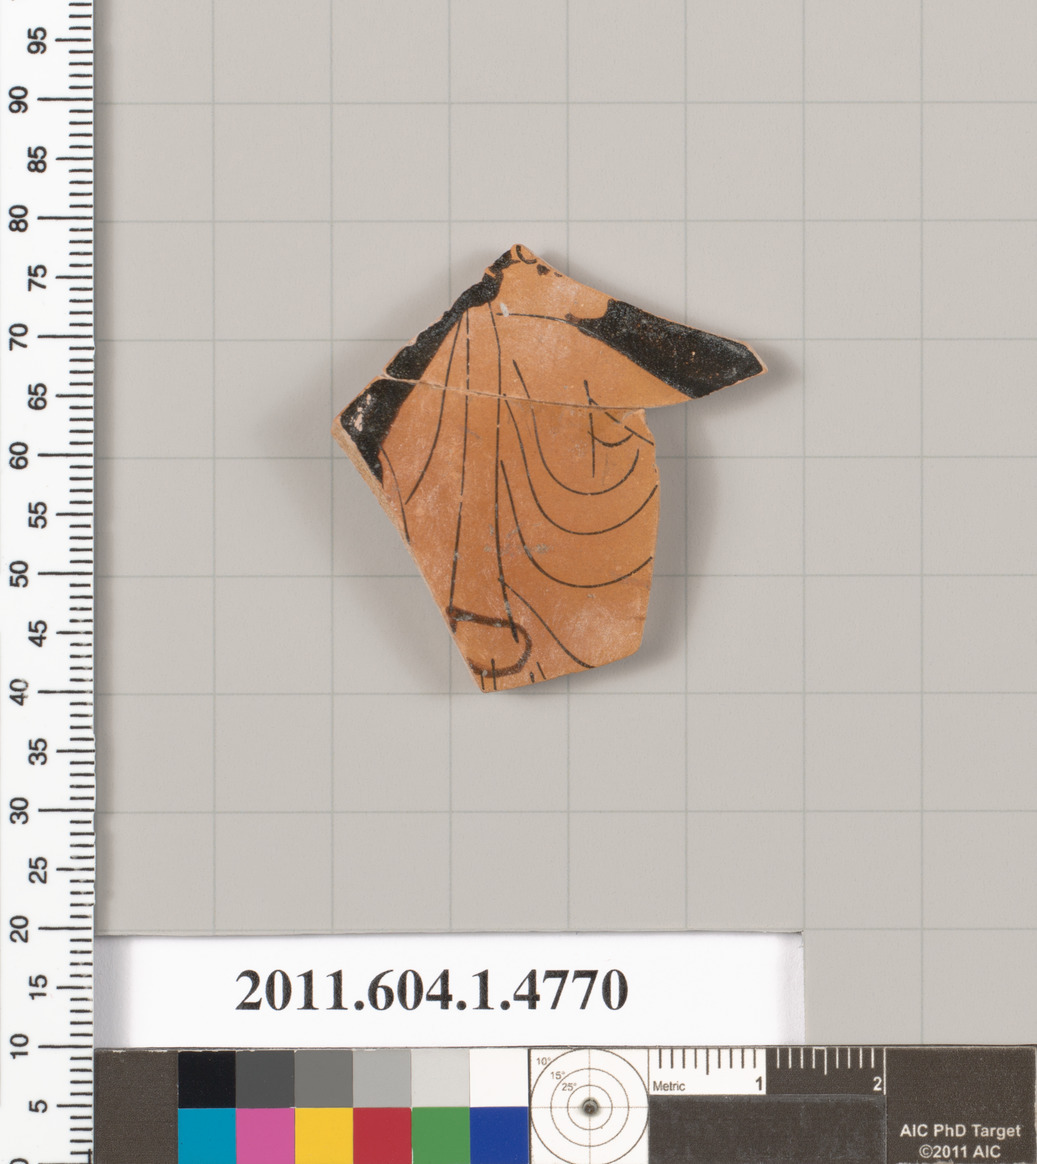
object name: kylix fragment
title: Terracotta fragment of a kylix (drinking cup)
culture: greek, attic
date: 475-451 BCE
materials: terracotta